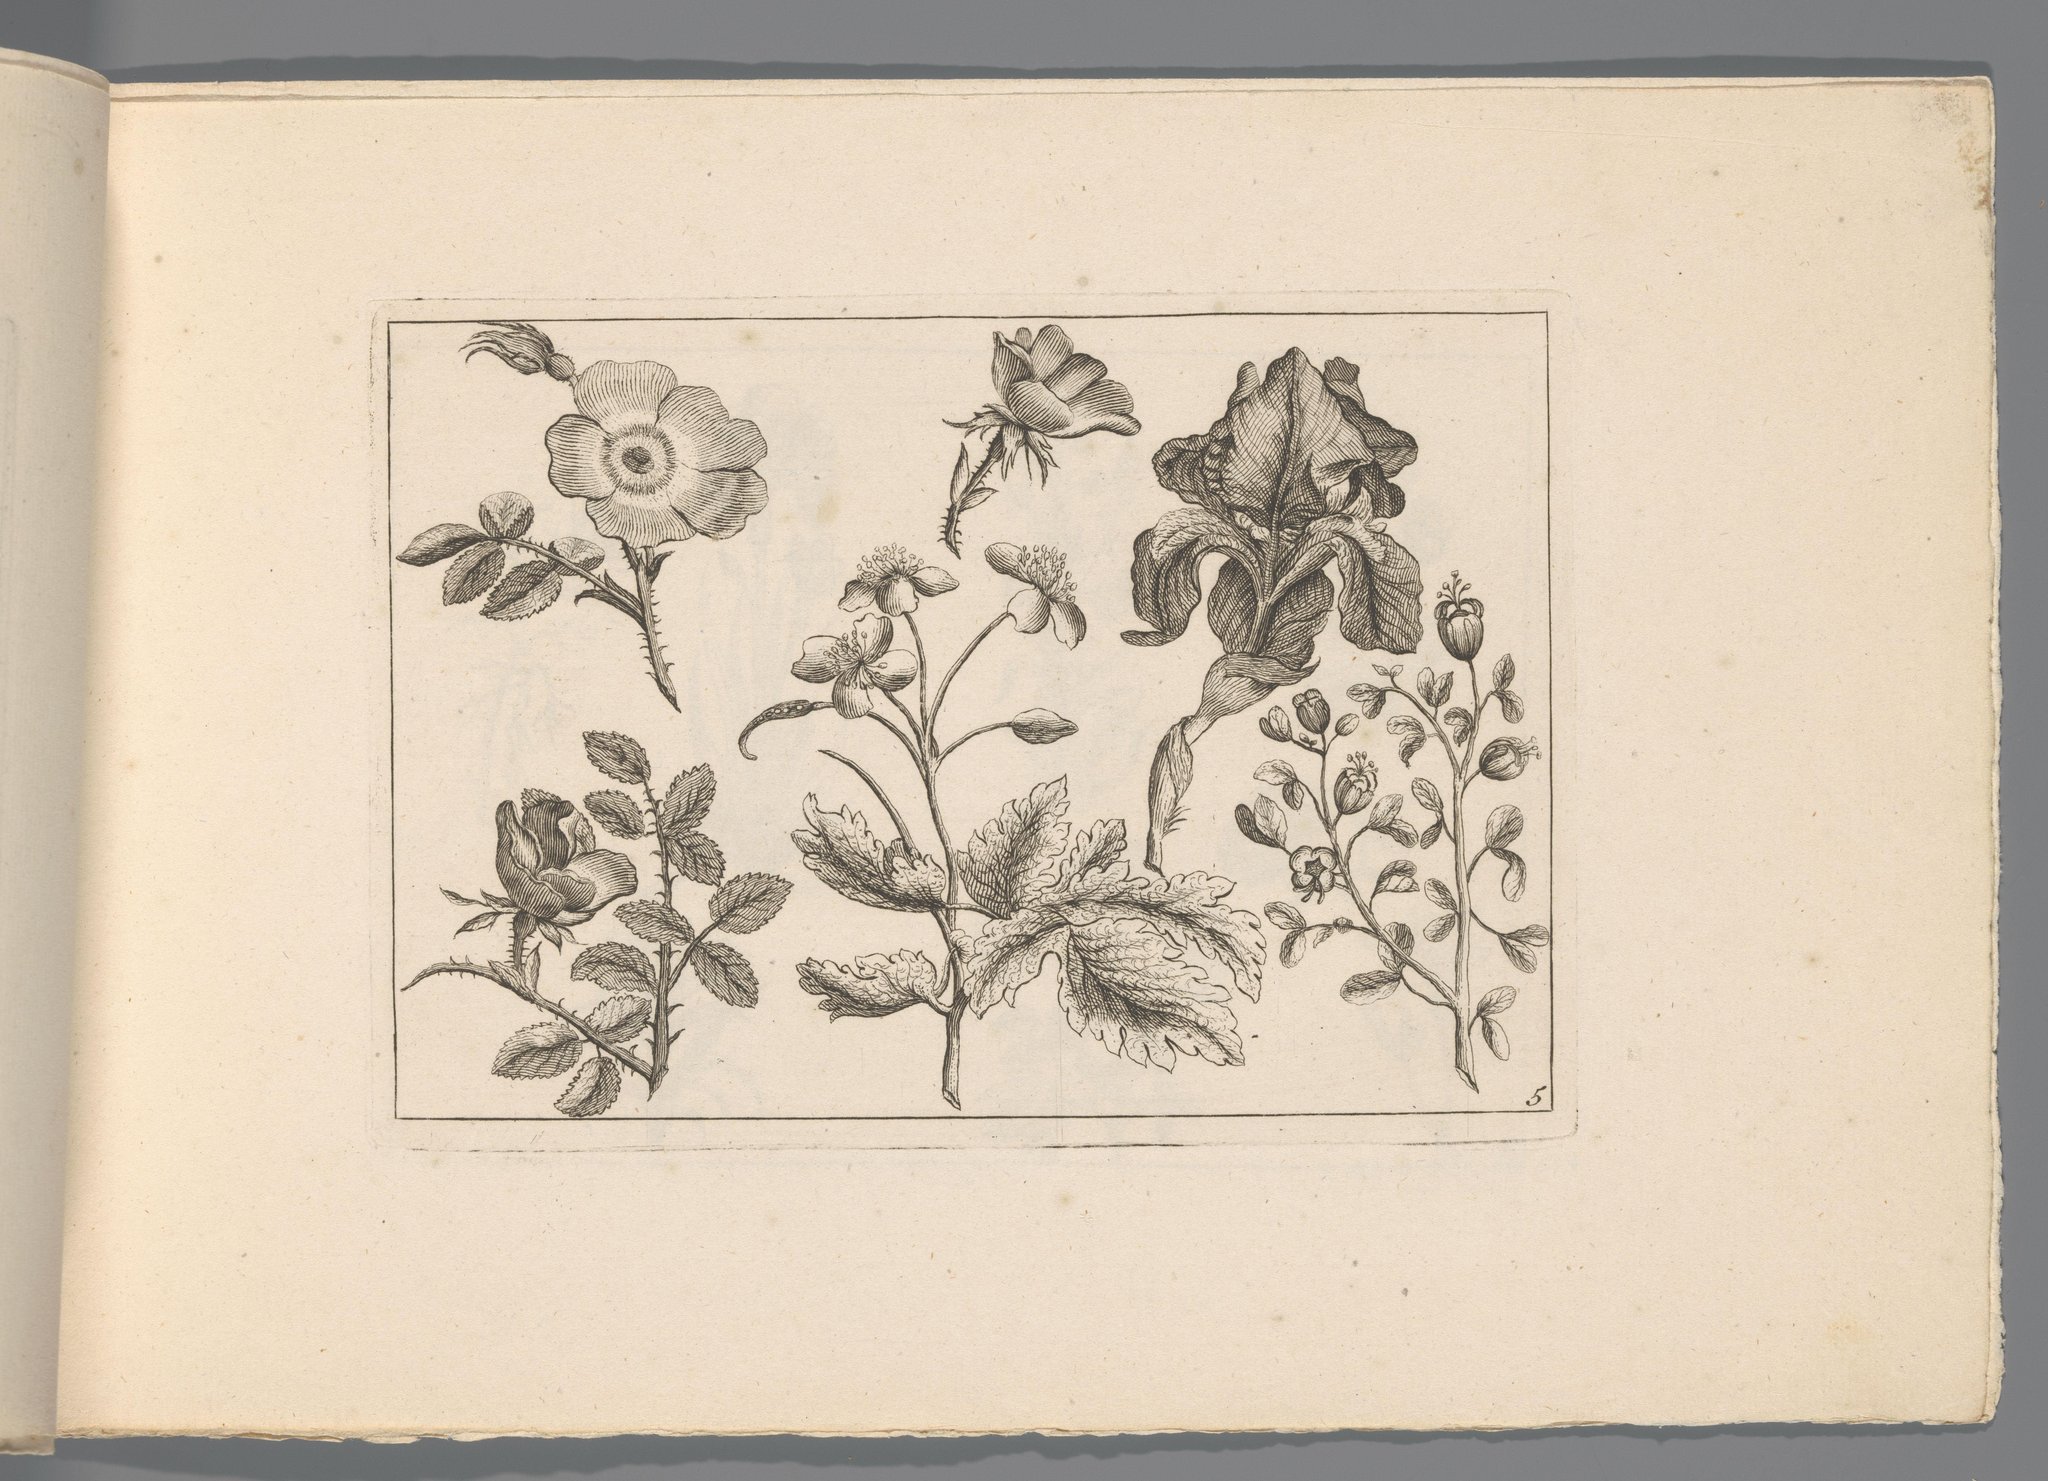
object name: ornament print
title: Rozen en andere bloemen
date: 1705-1730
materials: paper, fiber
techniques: engraving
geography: amsterdam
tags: flowers: rose, flowers: iris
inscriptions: collector's mark: Lugt 2228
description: De prent maakt deel uit van een samengebonden, genummerde serie van acht prenten met bloemen. De serie bestond oorspronkelijk waarschijnlijk uit twaalf prenten.